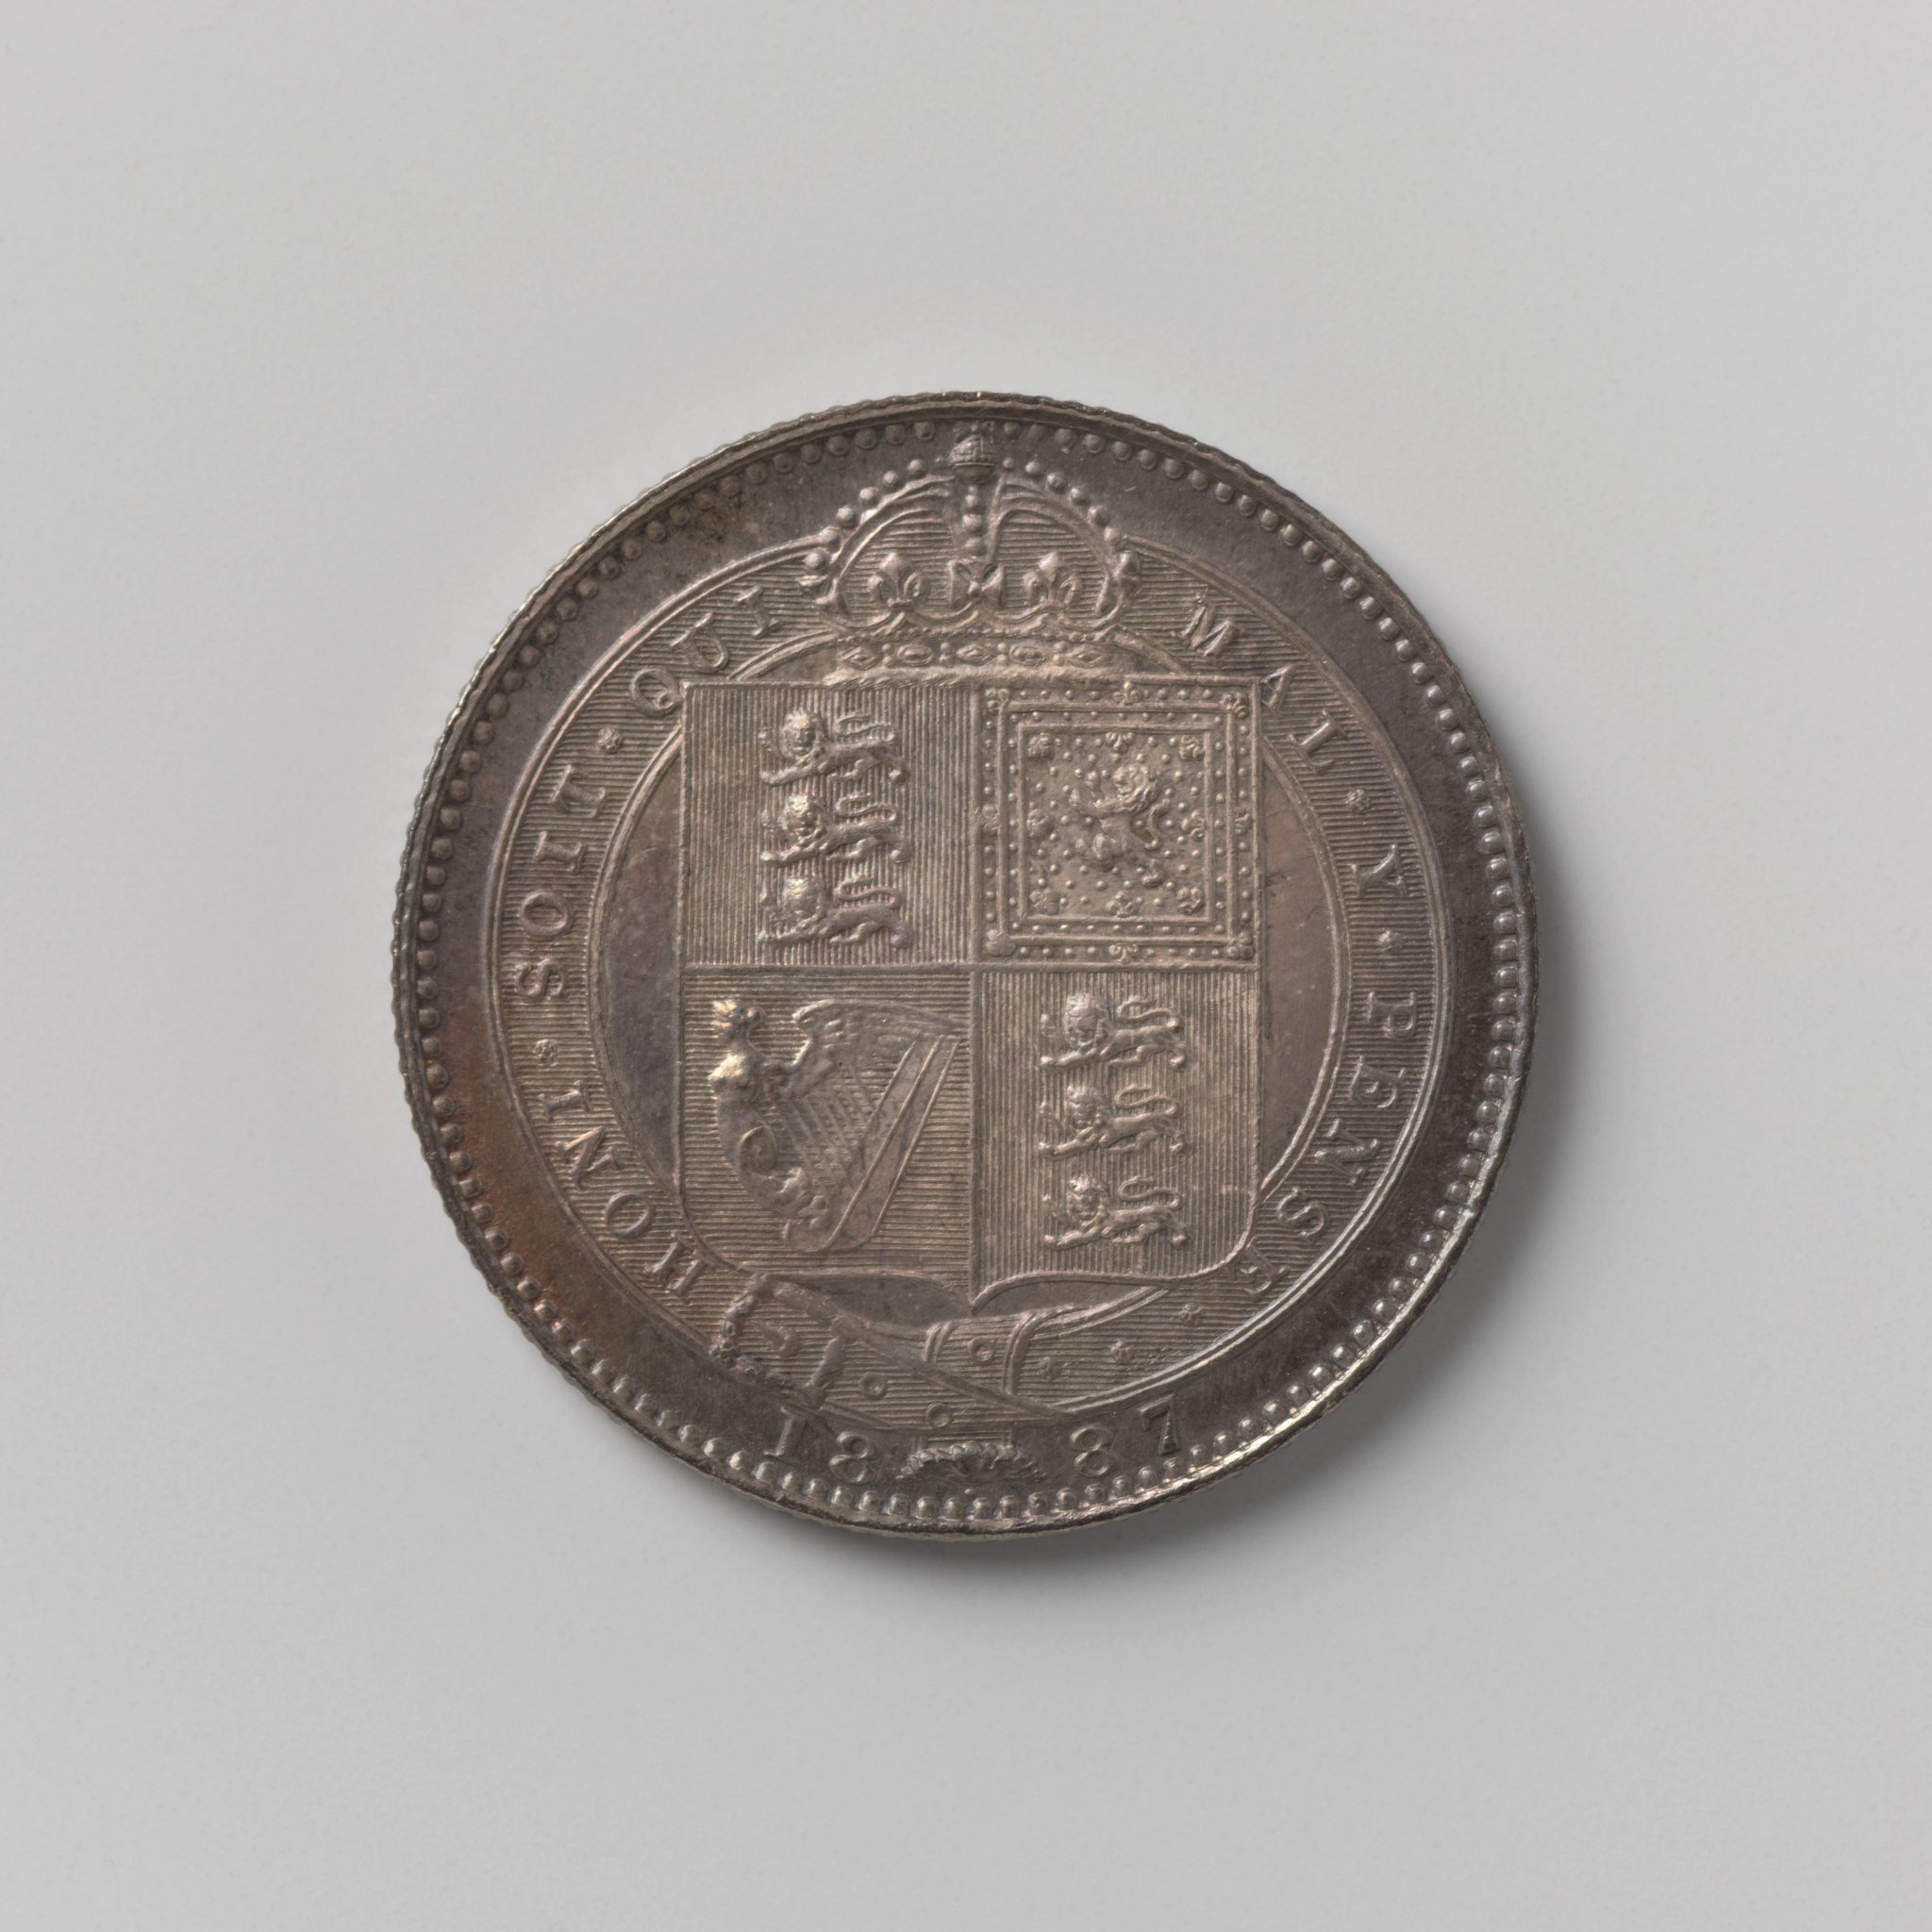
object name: coin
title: ½ crown uit Engeland van Victoria, 1887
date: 1887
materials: silver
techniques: striking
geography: london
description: Zilveren munt. Voorzijde: gekroond hoofd van de koningin naar links [jubilee coinage]. Keerzijde: omhangen door het teken van de orde van de kousenband gekroond samengesteld wapenschild. Jaartal onderaan. Kartelrand.